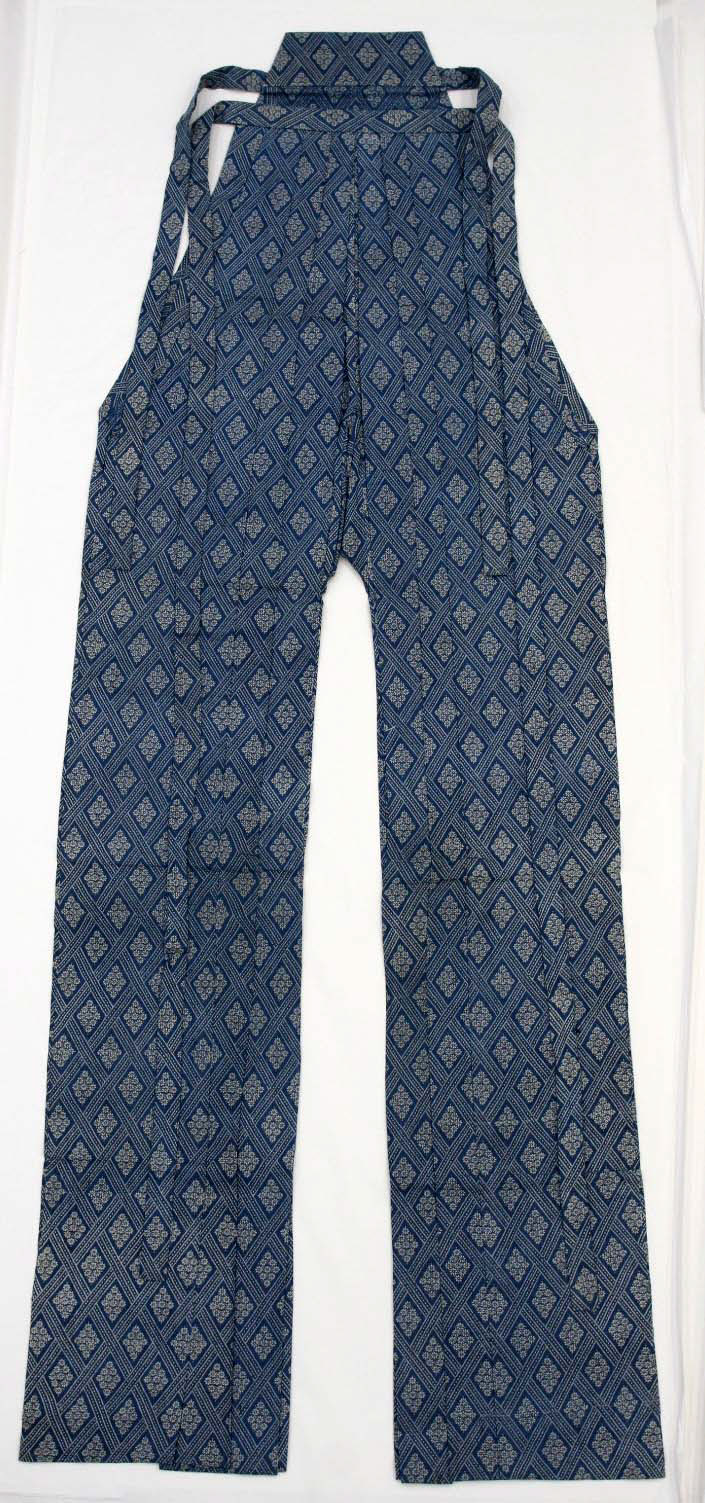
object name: trouser hakama associated with kyogen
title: Trousers ("hakama") associated with Kyogen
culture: japanese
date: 1867-1900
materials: hemp